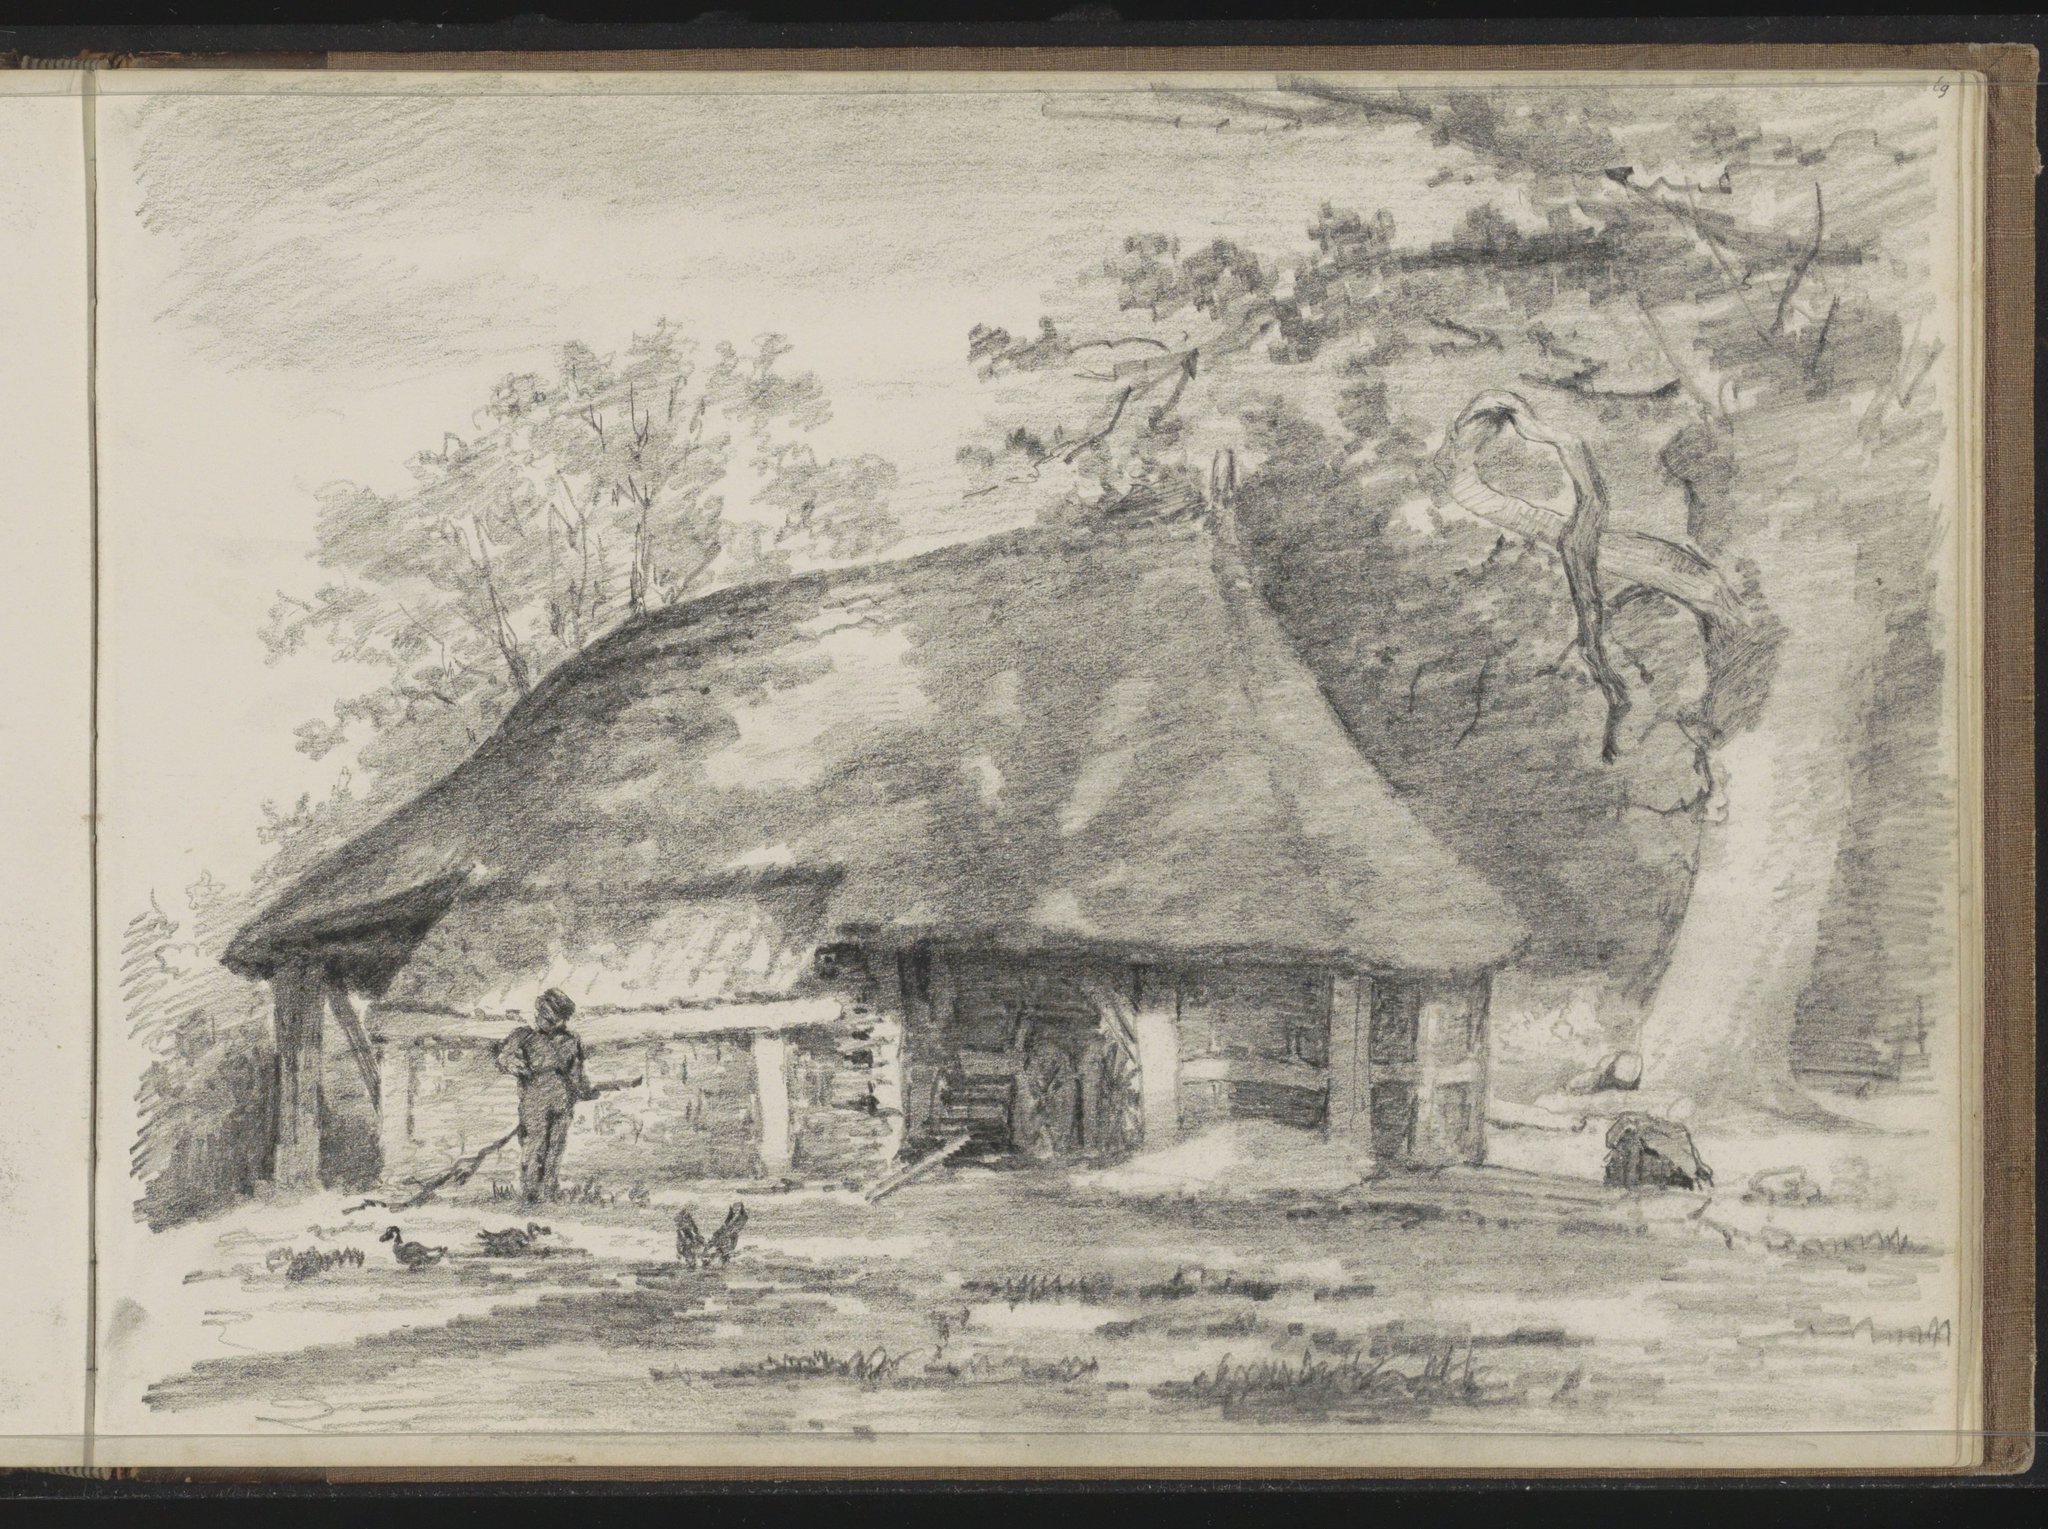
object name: sketchbook leaf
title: Man met tak voor een boerderij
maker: hendrik valkenburg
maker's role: draughtsman, painter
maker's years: 1826-1896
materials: paper, pencil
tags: fowl (cock, hen, chicken, etc.), farm (building)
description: Naast de man lopen eenden en kippen. Blad 69 recto uit een schetsboek met 77 bladen.